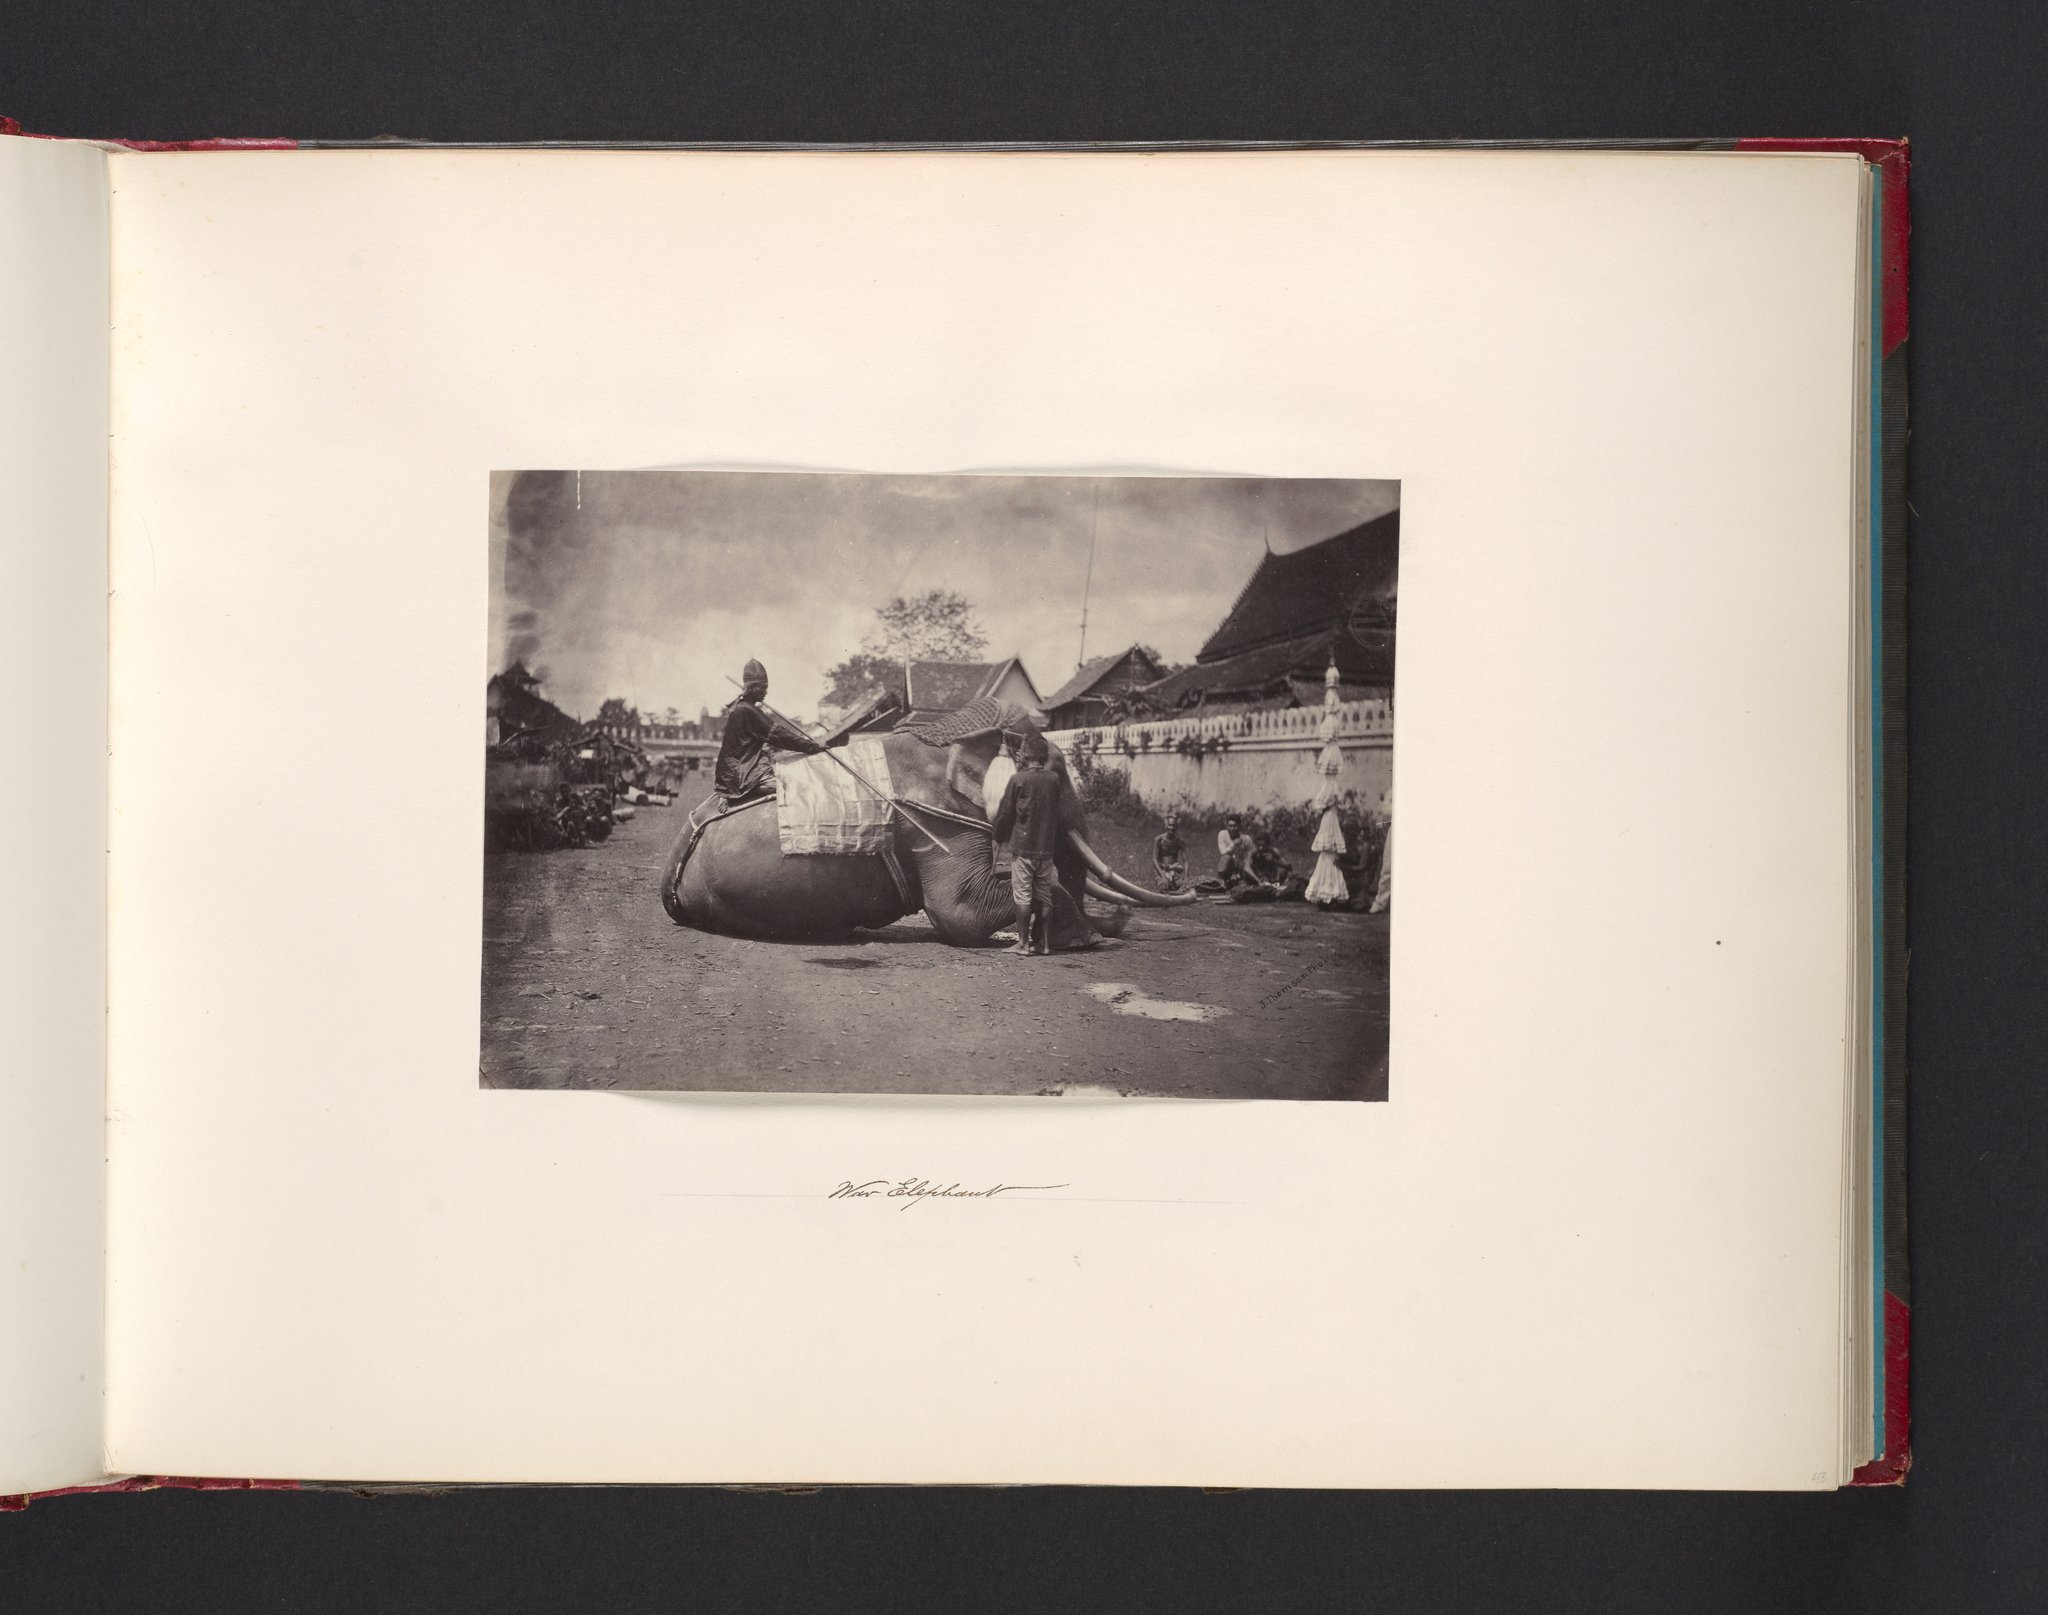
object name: photograph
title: Wat Elephant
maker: john thomson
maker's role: artist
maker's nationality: british, scottish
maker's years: 1837-1921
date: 1865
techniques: albumen silver print, glass negative